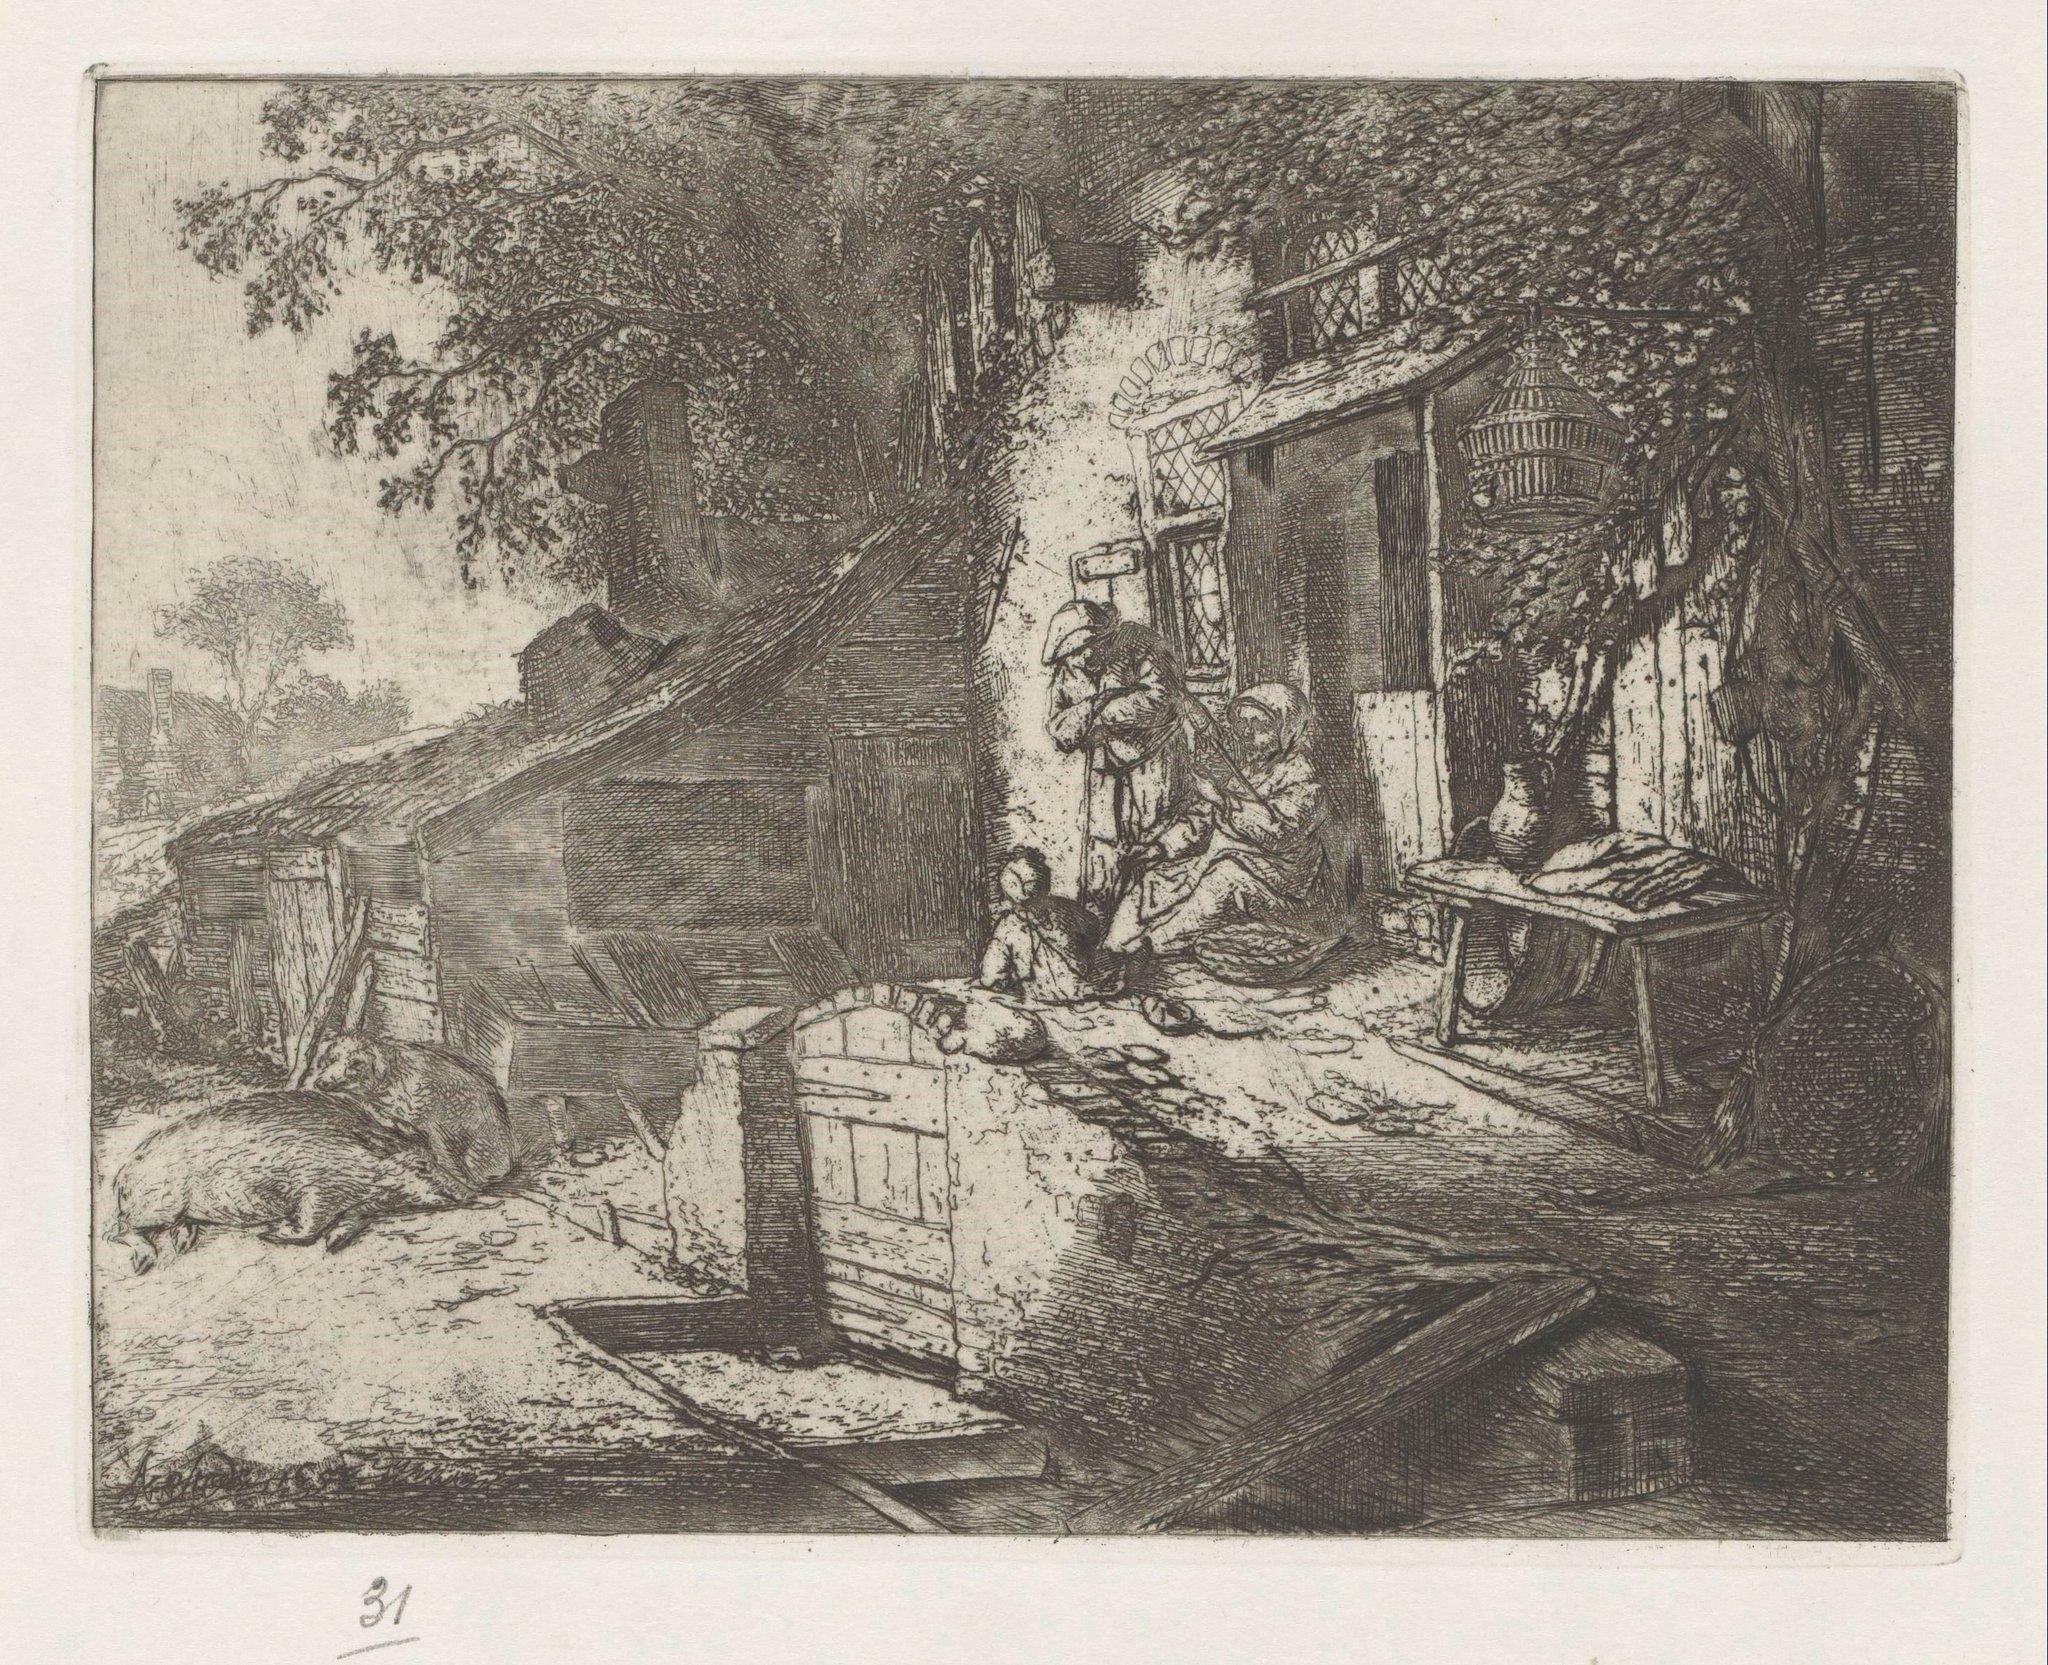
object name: print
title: Spinnende vrouw voor een huis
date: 1652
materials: paper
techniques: etching, galvanization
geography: haarlem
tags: spindle, mother and baby or young child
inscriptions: collector's mark: ‘B’, collector's mark: ‘RIJKS / MUSM’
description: Op het erf voor de deur van een huis zit een vrouw te spinnen. Naast haar staat een man met een hand in zijn hemd gestoken. Op de grond speelt een kind. Voor een stal rusten twee varkens en tegen de gevel van het huis staan allerlei huishoudelijke attributen zoals een bezem en rieten mand. De prent maakt deel uit van een portefeuille.